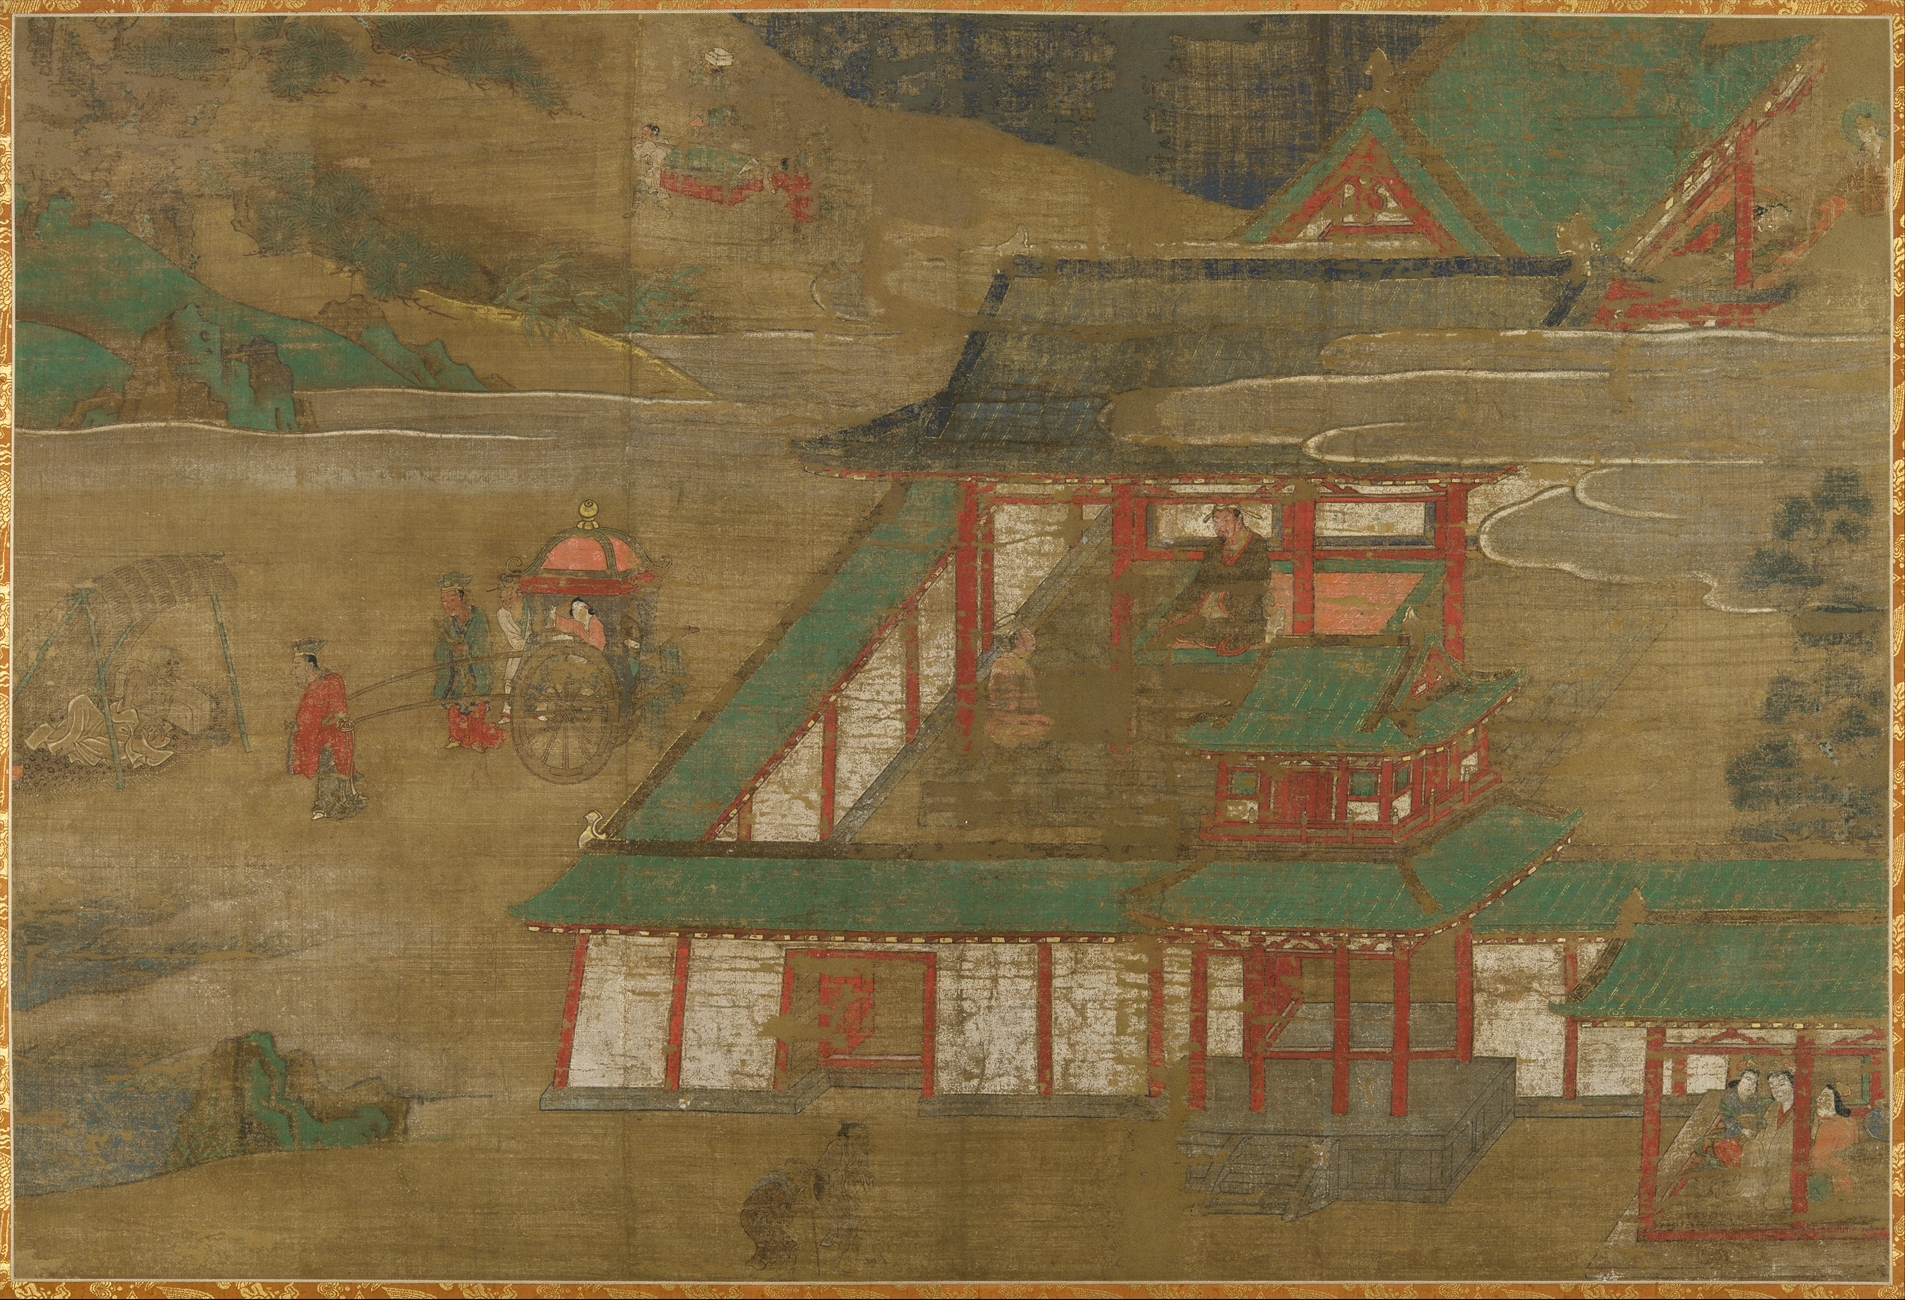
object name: hanging scroll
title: Scene from the Life of the Buddha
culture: japanese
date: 1401-1433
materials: gold, ink, panel, silk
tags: palaces,men,buddhism,buddha